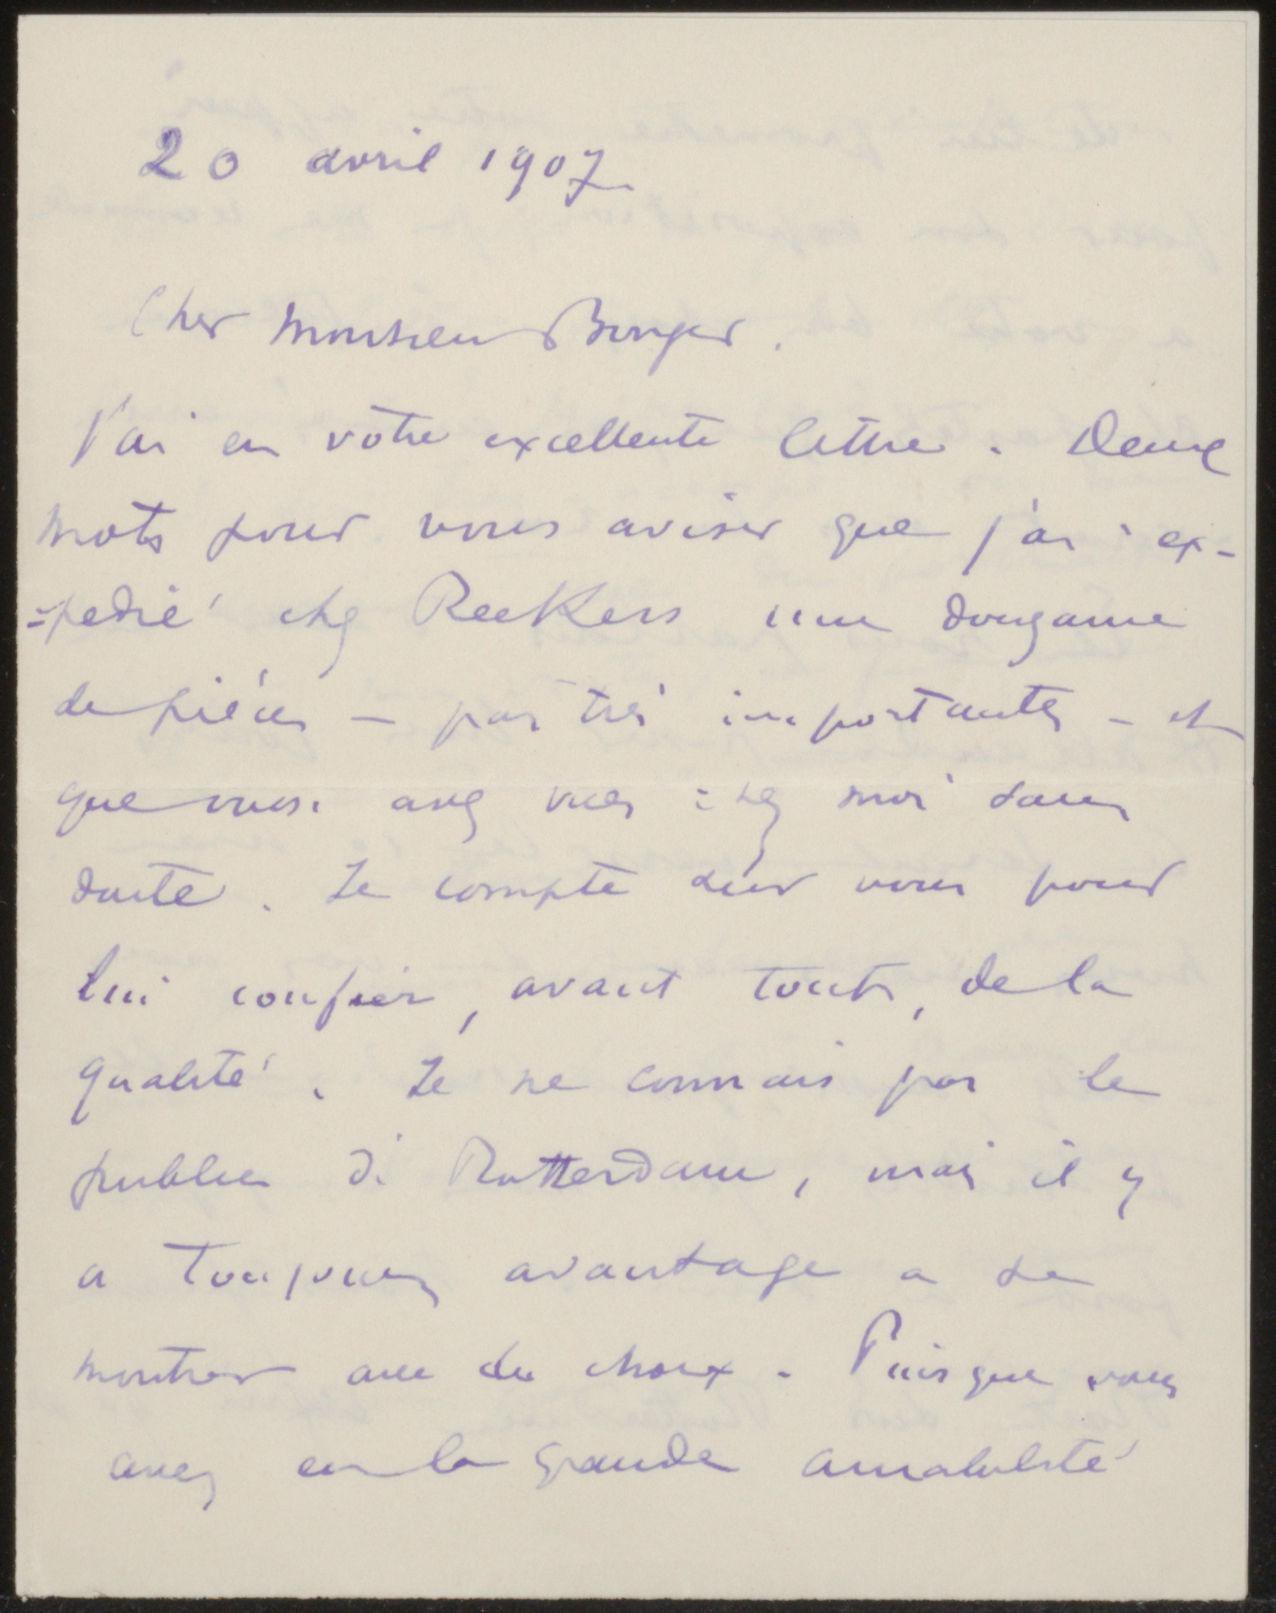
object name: letter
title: Brief aan Andries Bonger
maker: odilon redon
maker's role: draughtsman, painter, print maker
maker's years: 1840-1916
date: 1907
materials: ink, paper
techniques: pen, writing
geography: paris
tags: amsterdam, andries bonger, artist, leonardo da vinci, art trade, art shop, drawing, painting (including book-illumination, miniature-painting), exhibition ~ art, historical persons (portraits and scenes from the life), netherlands, rotterdam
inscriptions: watermark